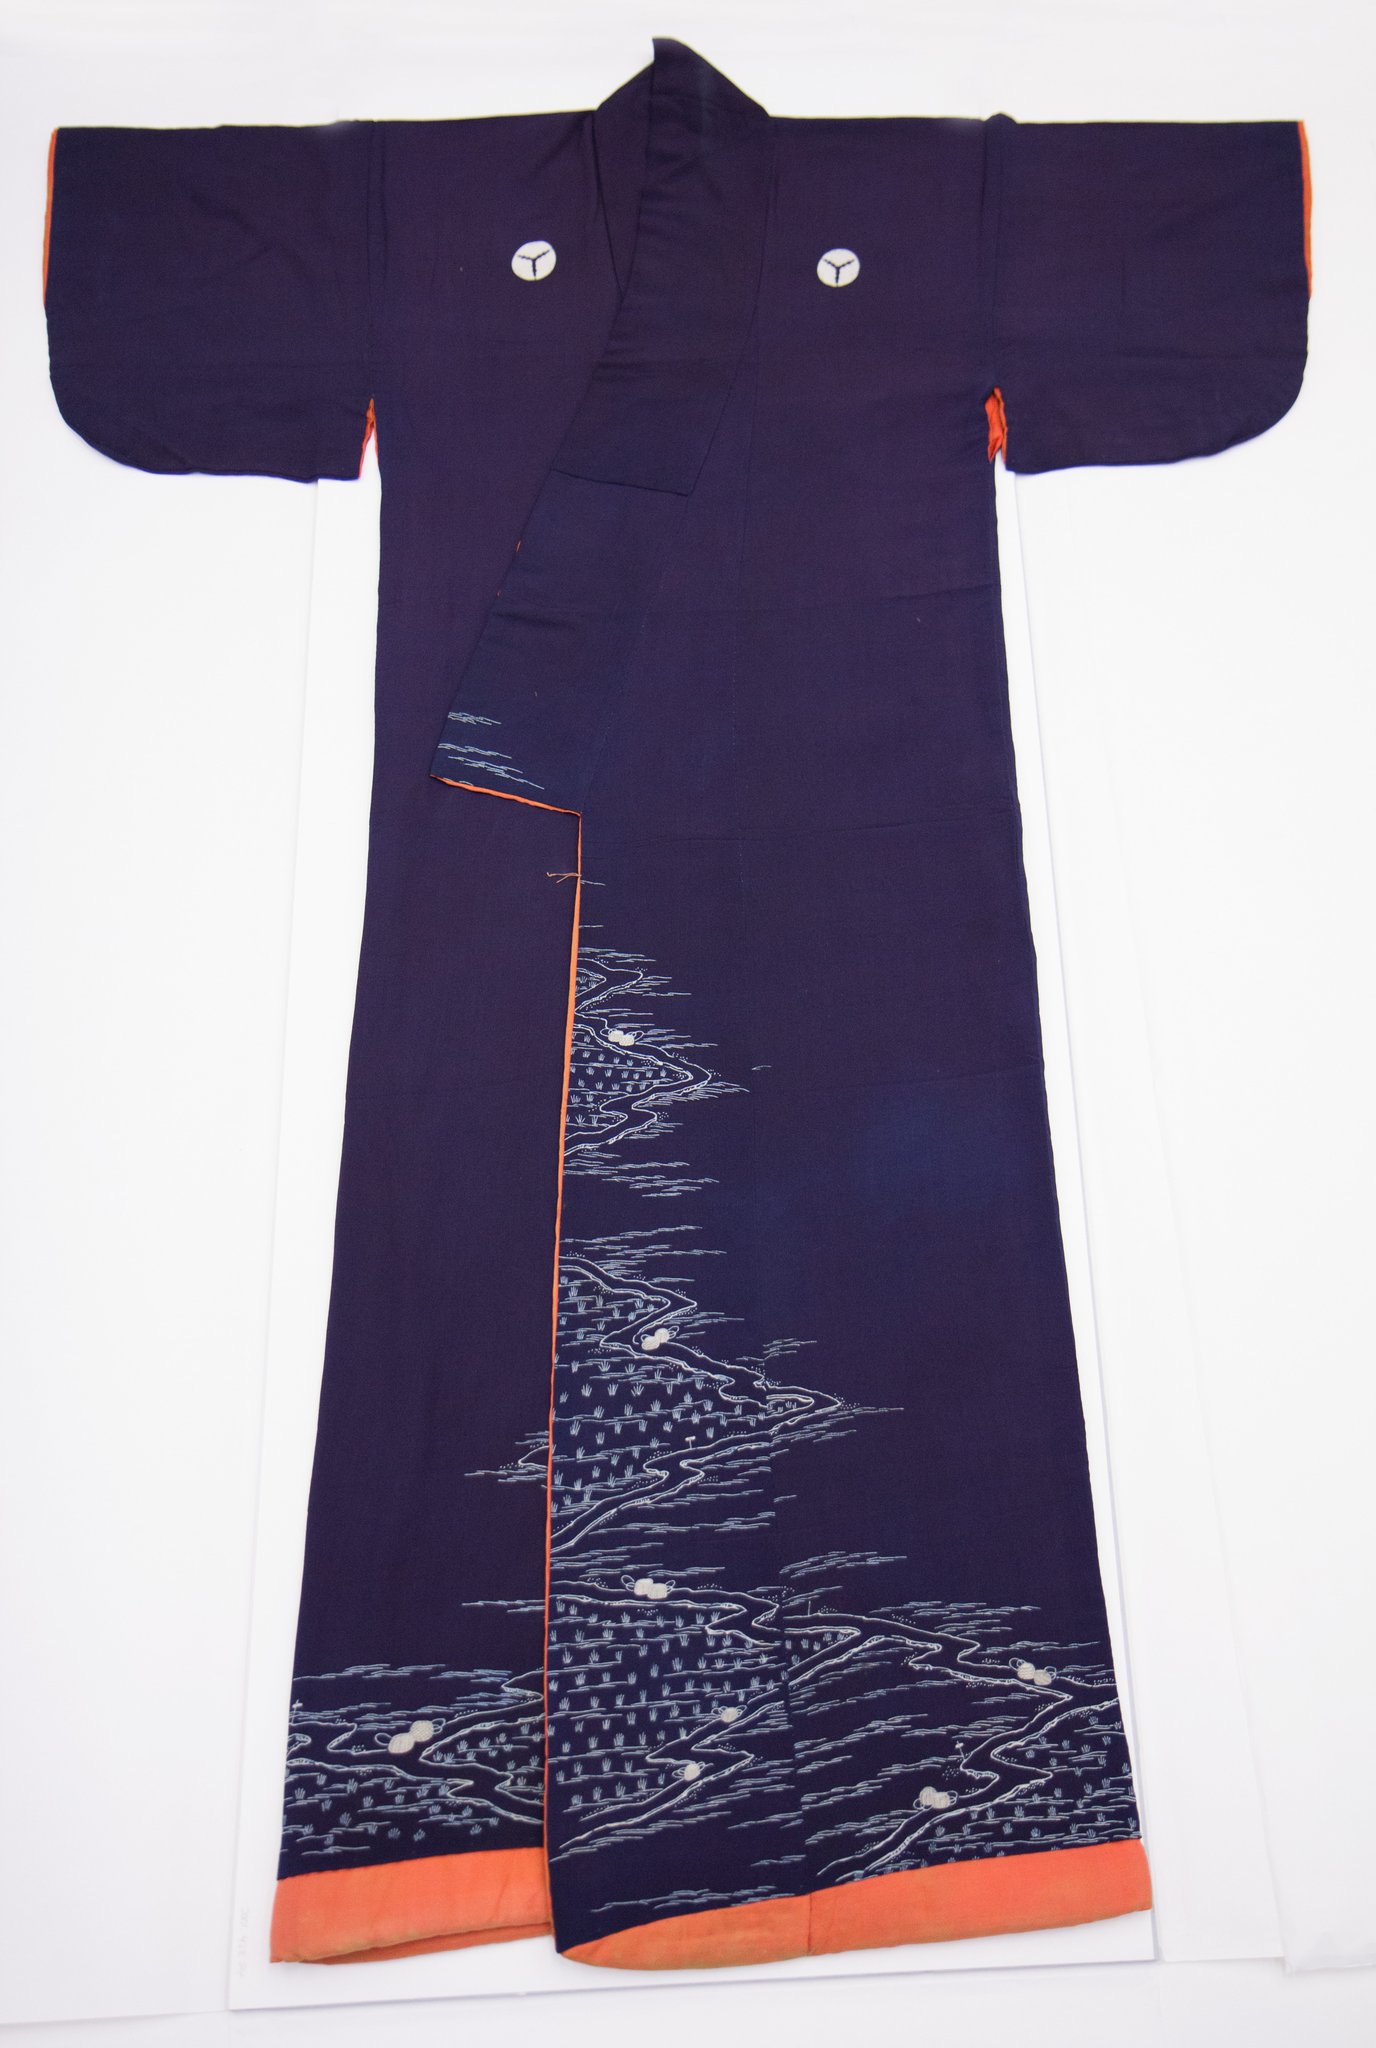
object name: kosode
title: Robe (Kosode) with Spring Rice Fields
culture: japanese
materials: silk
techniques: painting, weave, resist